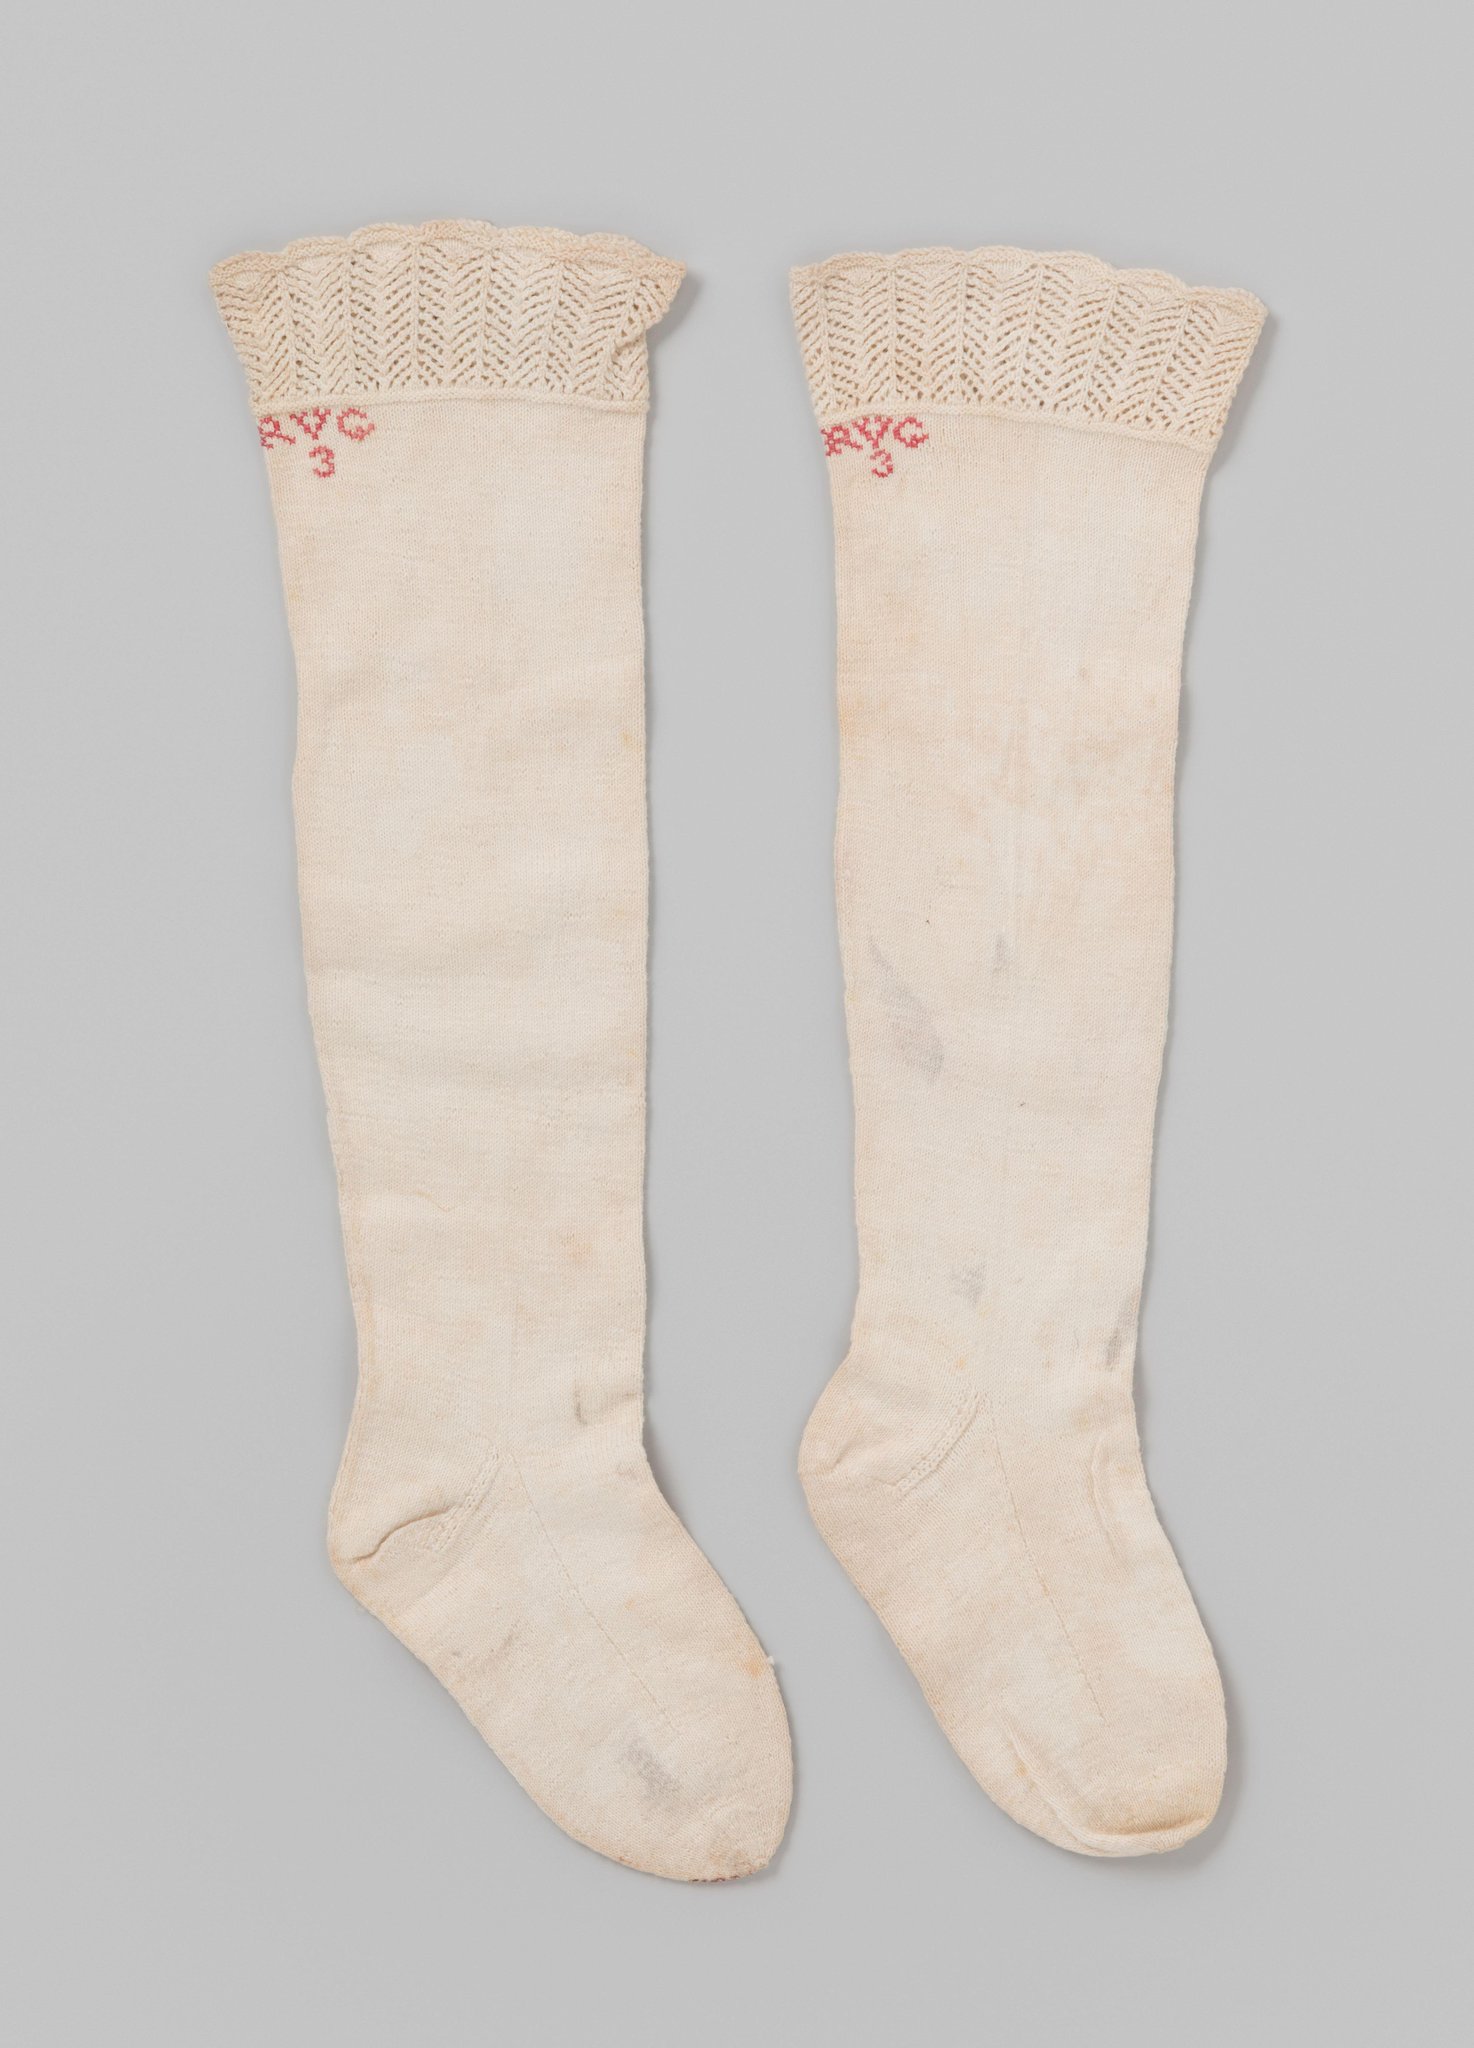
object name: childrenswear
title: Kous van effen gebreide witte katoen met ajour rand, kindermaat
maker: Anonymous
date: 1840-1850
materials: cotton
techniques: cross stitching, embroidery, knitting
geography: netherlands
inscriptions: mark: ‘'IRvG 3'’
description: Kous van effen gebreide witte katoen met ajour rand, kindermaat. Gemerkt in rode kruissteek: 'IRvG 3'. Deel van een paar.